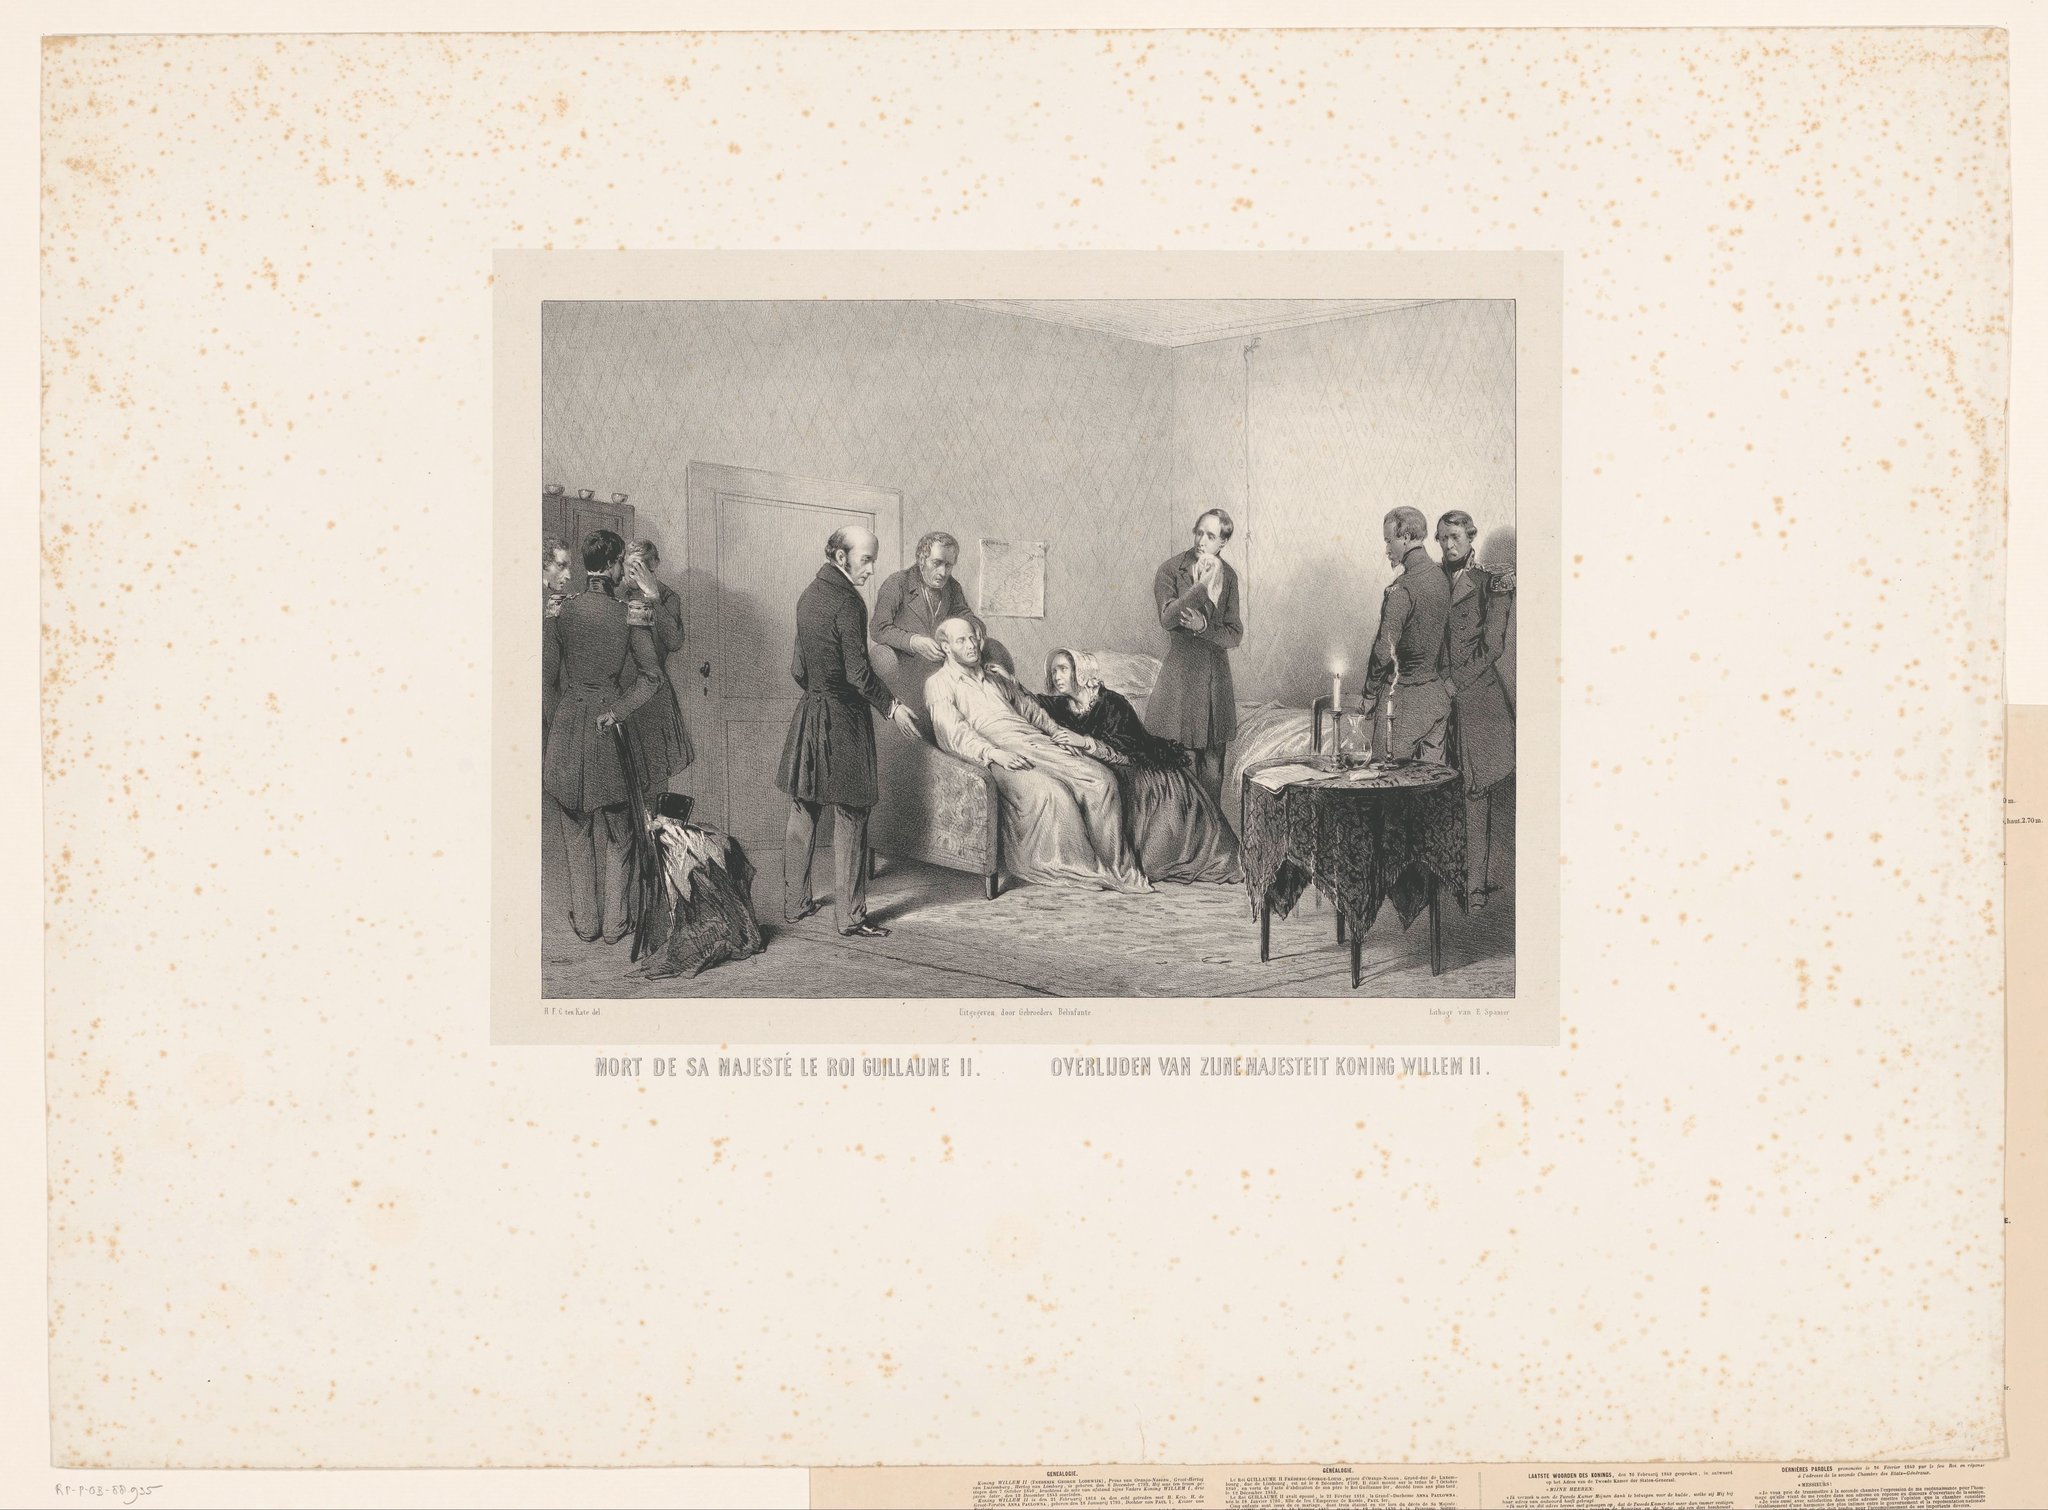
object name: print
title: Mort de Sa Majesté le Roi Guillaume II / Overlijden van Zijne Majesteit Koning Willem II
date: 1849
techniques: printmaking, lithograph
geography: the hague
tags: anna paulowna romanowa, william ii of the netherlands, hendrik (prins der nederlanden), deathbed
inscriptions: collector's mark: Lugt 2228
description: Het overlijden van koning Willem II in Tilburg op 17 maart 1849. De koning sterft zittend in een stoel in een kamer, aan zijn voeten knielt zijn echtgenote Anna Paulowna. Achter haar staat prins Hendrik, rechts de adjudanten Coehoorn en Merkes. Links van de koning de kamerheer Matthijs, de arts Everard. Meer naar links de artsen Maes en Van Hees en de kamerheer Aerts. Bij de prent behoren een afzonderlijke verklaring en omslag.